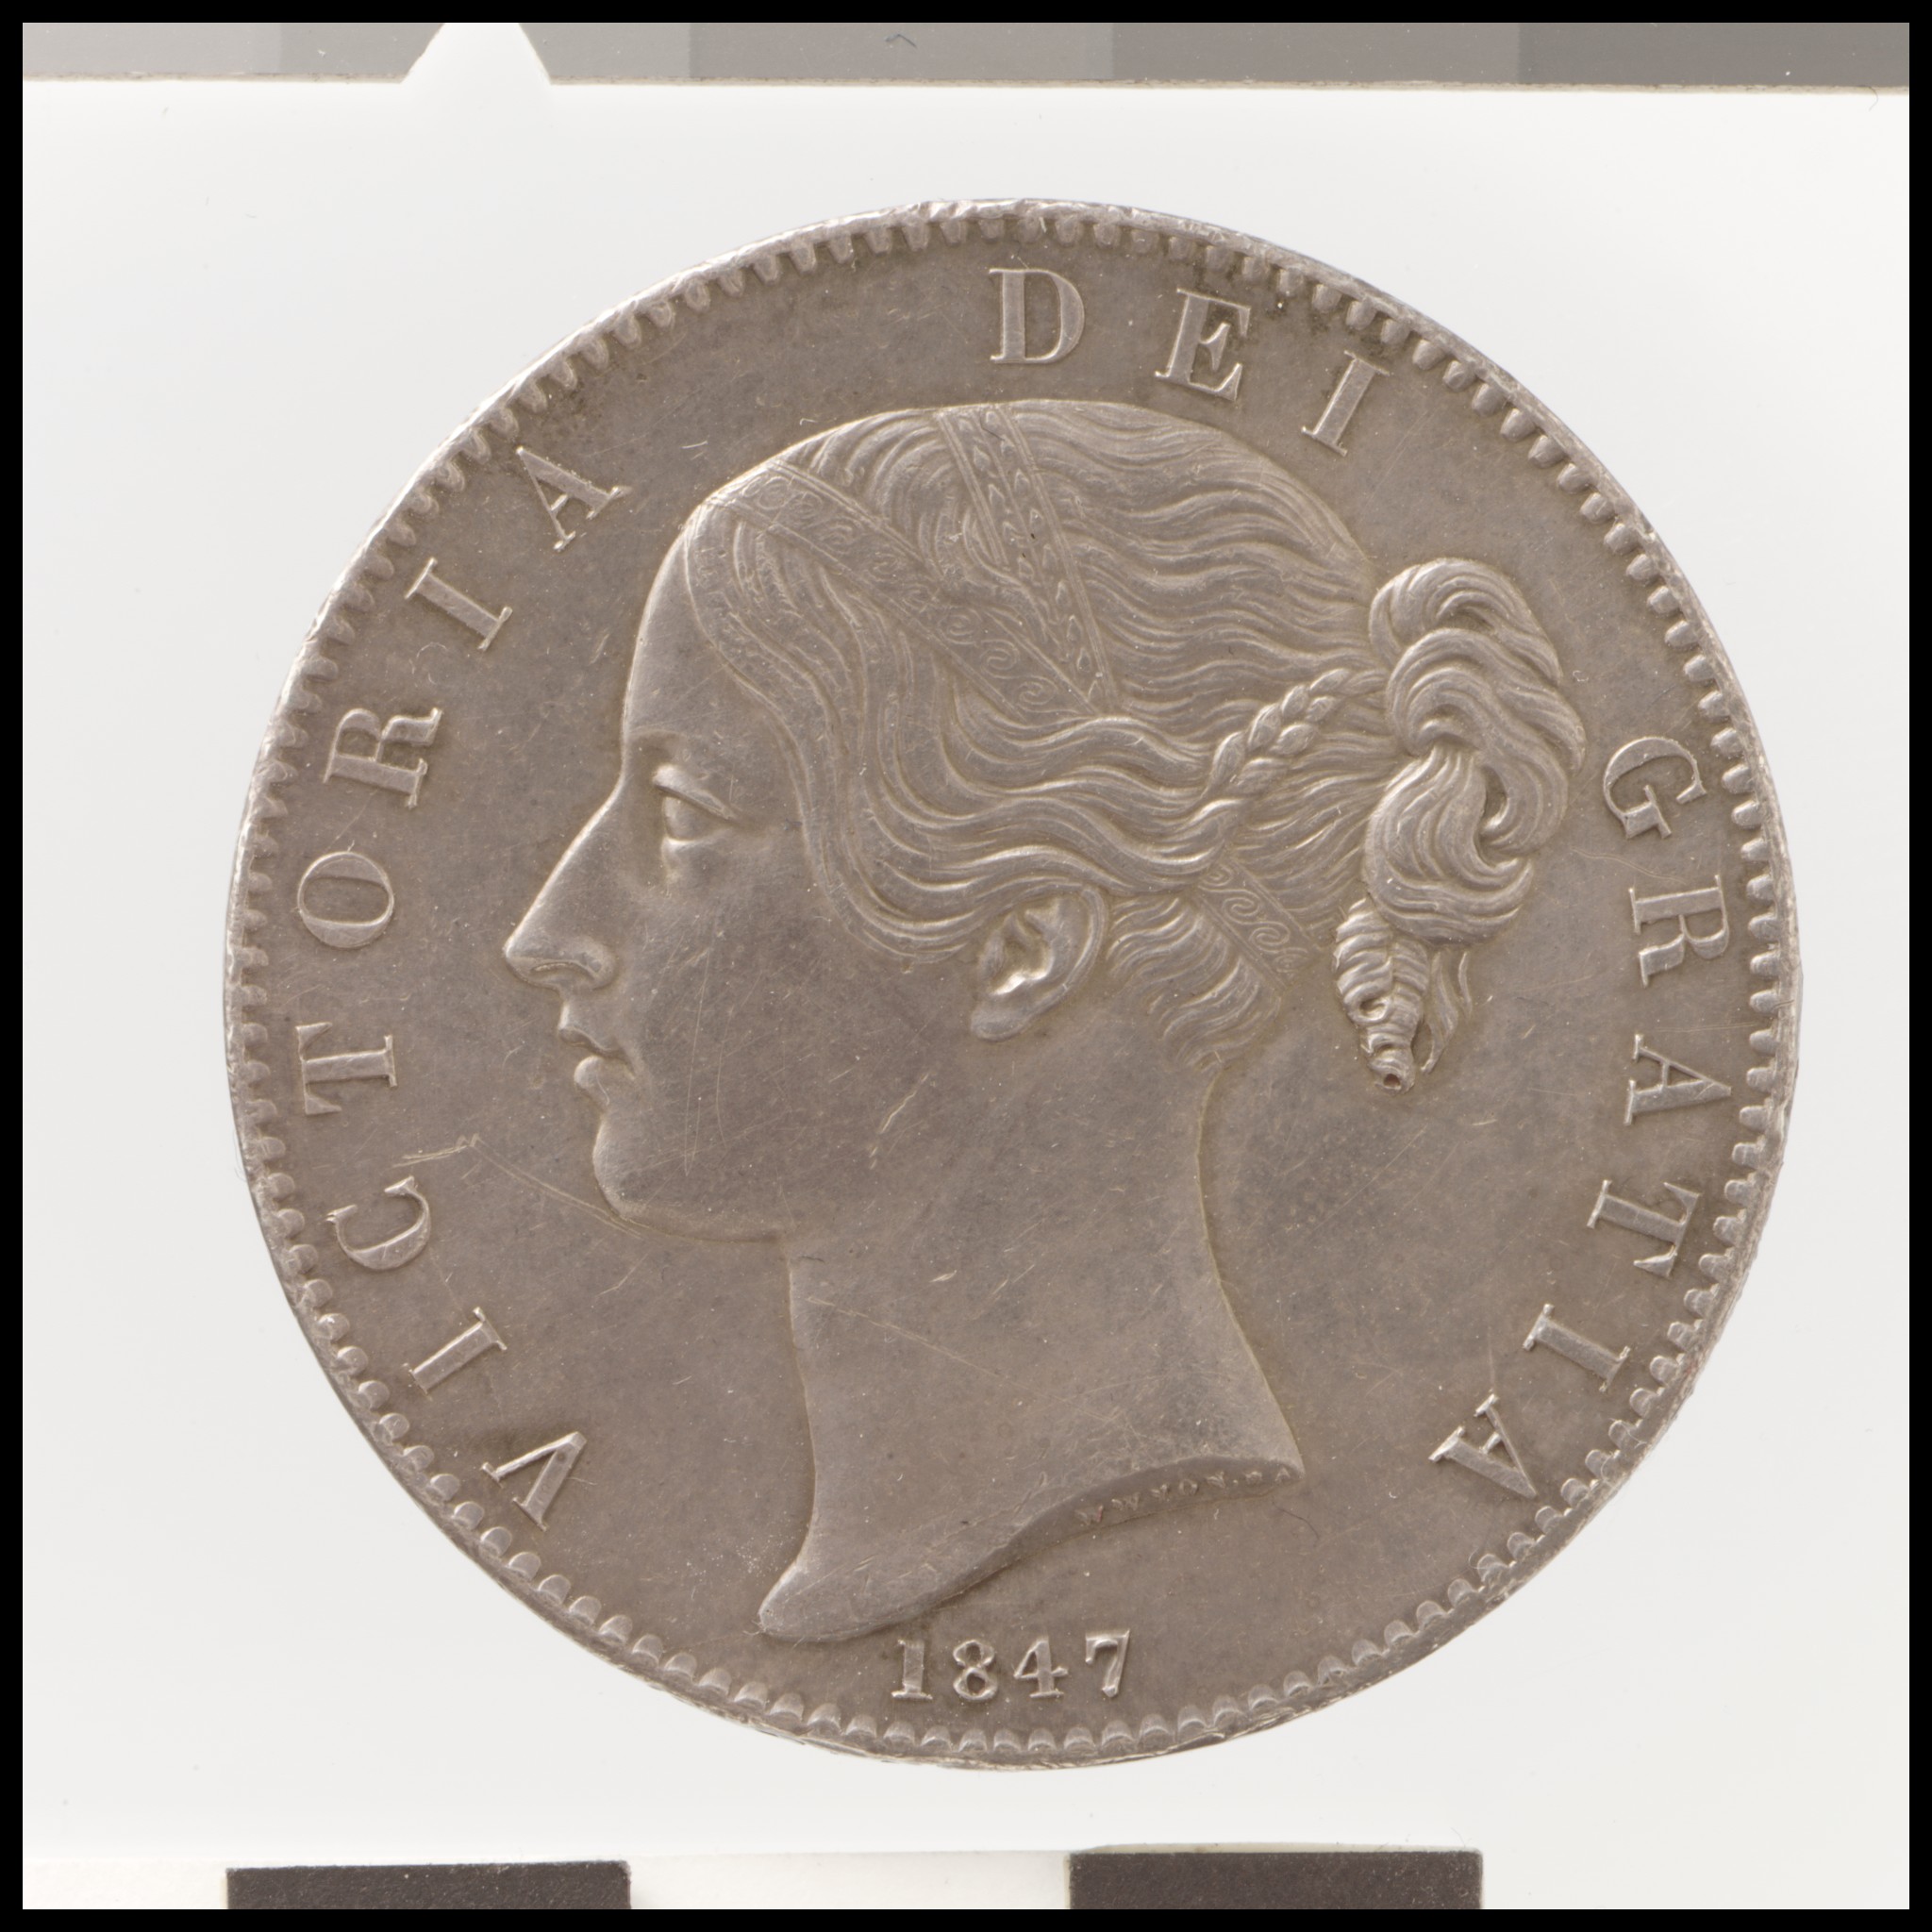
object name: crown coin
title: Victoria crown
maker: william wyon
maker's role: artist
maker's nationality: british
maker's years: 1795-1851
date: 1847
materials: silver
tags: profiles,coat of arms